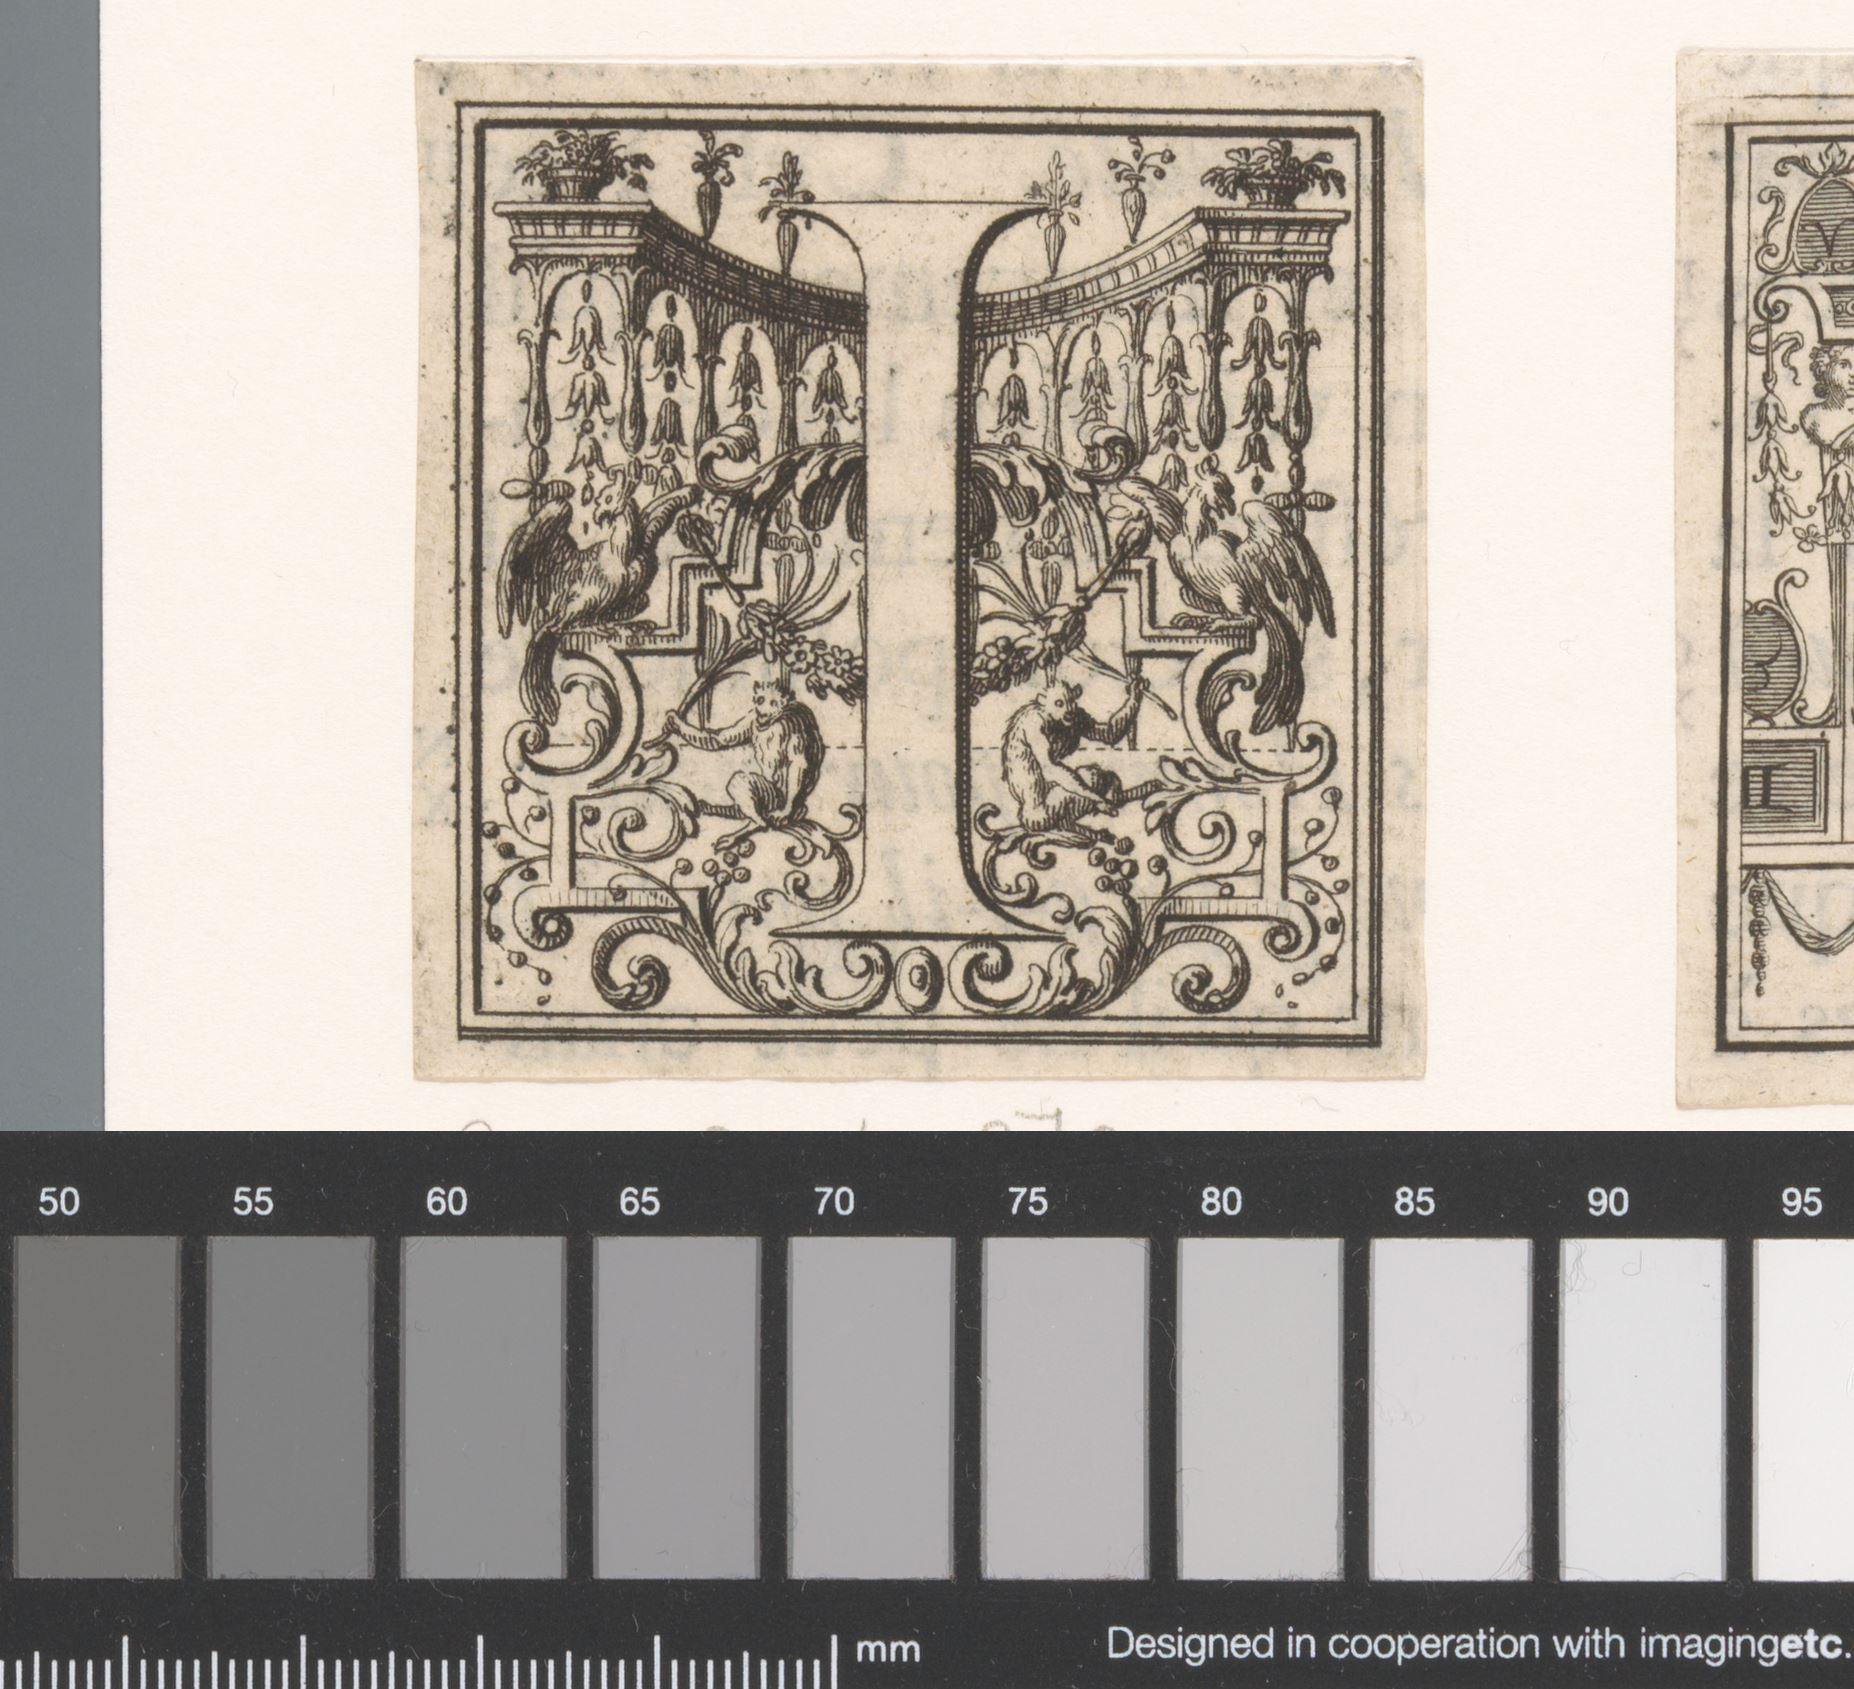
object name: print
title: Letter I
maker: Anonymous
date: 1700-1799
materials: paper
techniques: etching, letterpress printing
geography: france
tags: fancy letters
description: Letter I tegen een achtergrond met vlechtwerk, apen en vogels.